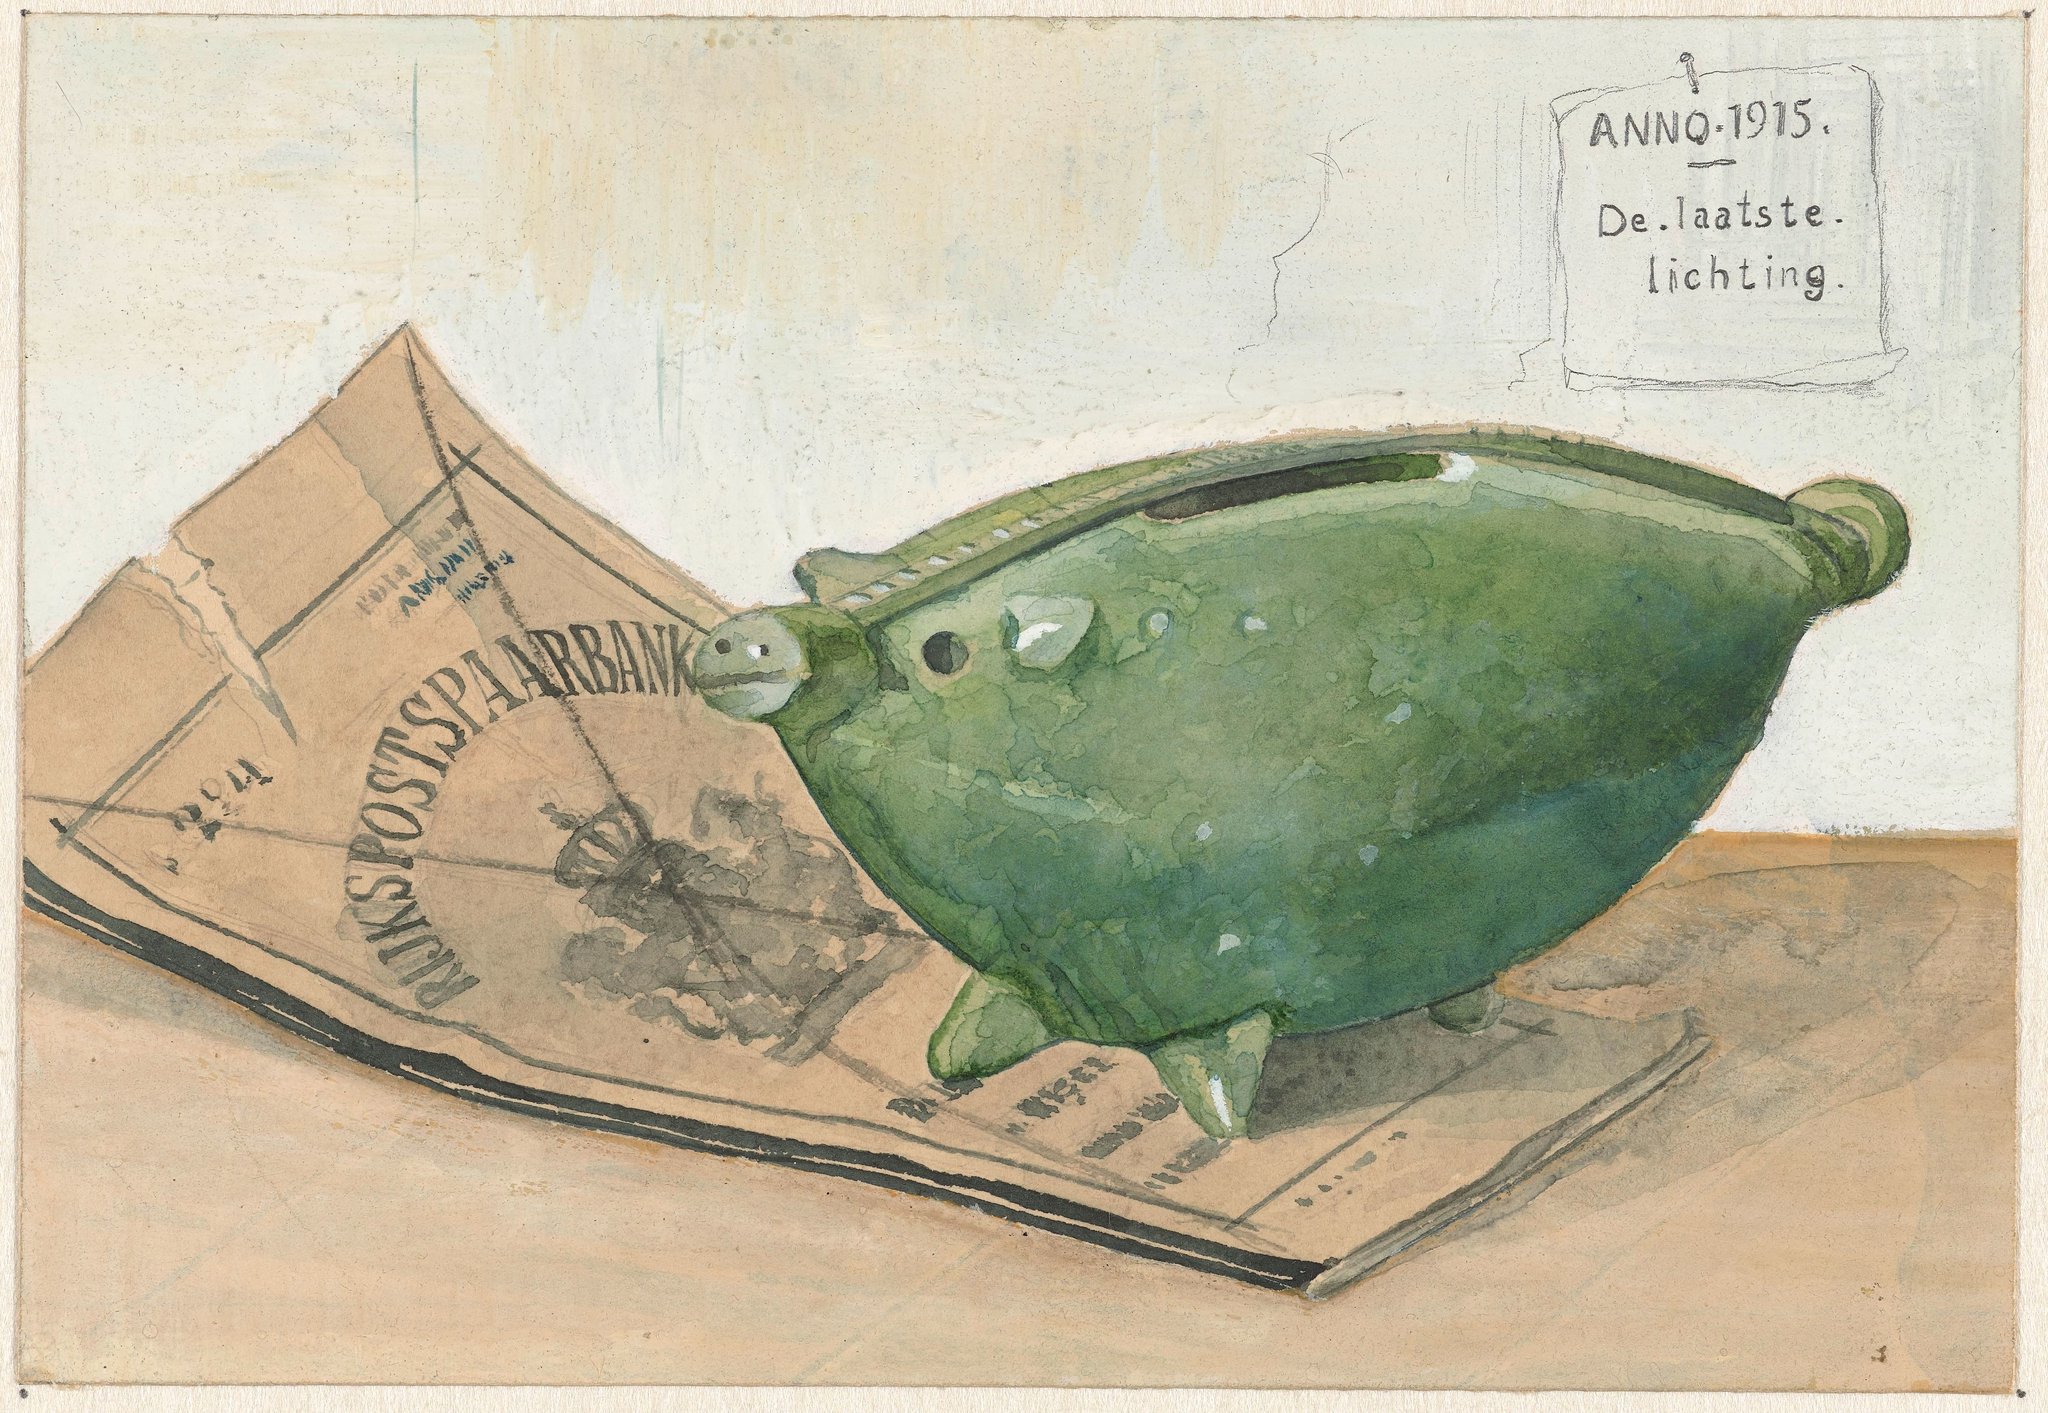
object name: watercolor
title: Spaarvarken en spaarbankboekje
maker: frans everbag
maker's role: draughtsman, print maker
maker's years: 1877-1947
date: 1915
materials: paint, paper, pencil, watercolor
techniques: brush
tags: money-chest, treasure-chest, money-box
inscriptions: date: ‘1915’